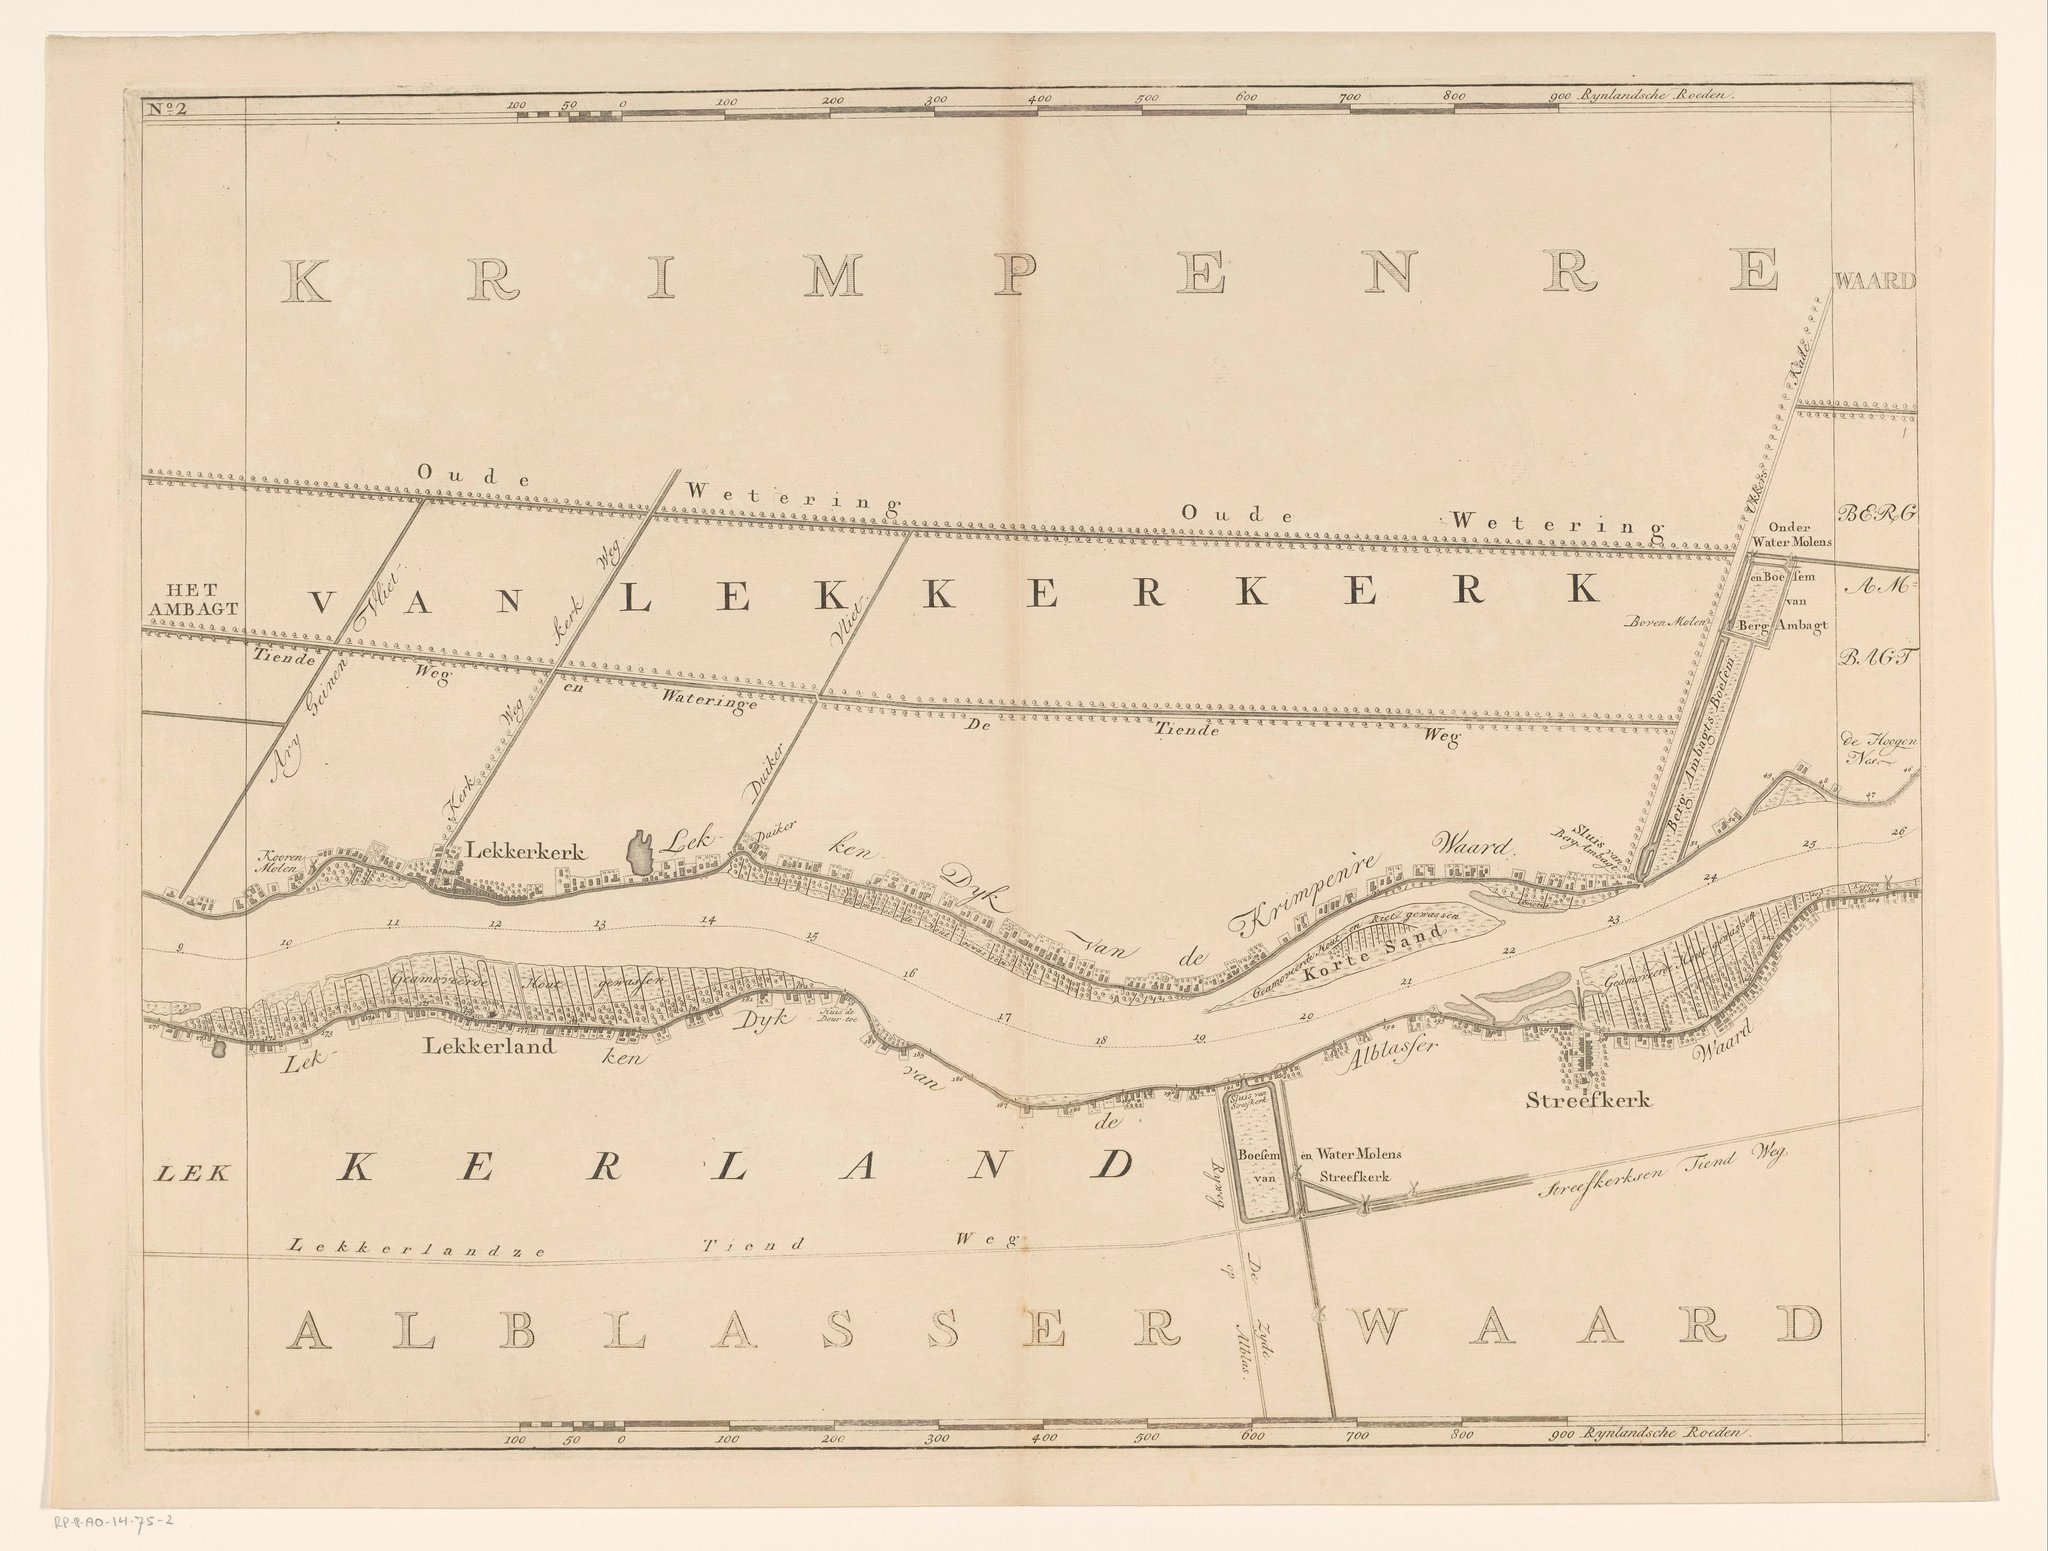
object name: print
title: Kaart van de rivier de Lek (tweede deel)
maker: isaak tirion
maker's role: publisher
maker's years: 1705-1765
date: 1764-1765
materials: paper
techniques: engraving, etching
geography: amsterdam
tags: maps of separate countries or regions, river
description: Tweede deel van een kaart van de rivier de Lek, bestaande uit zeven delen. Linksboven genummerd: No. 2.